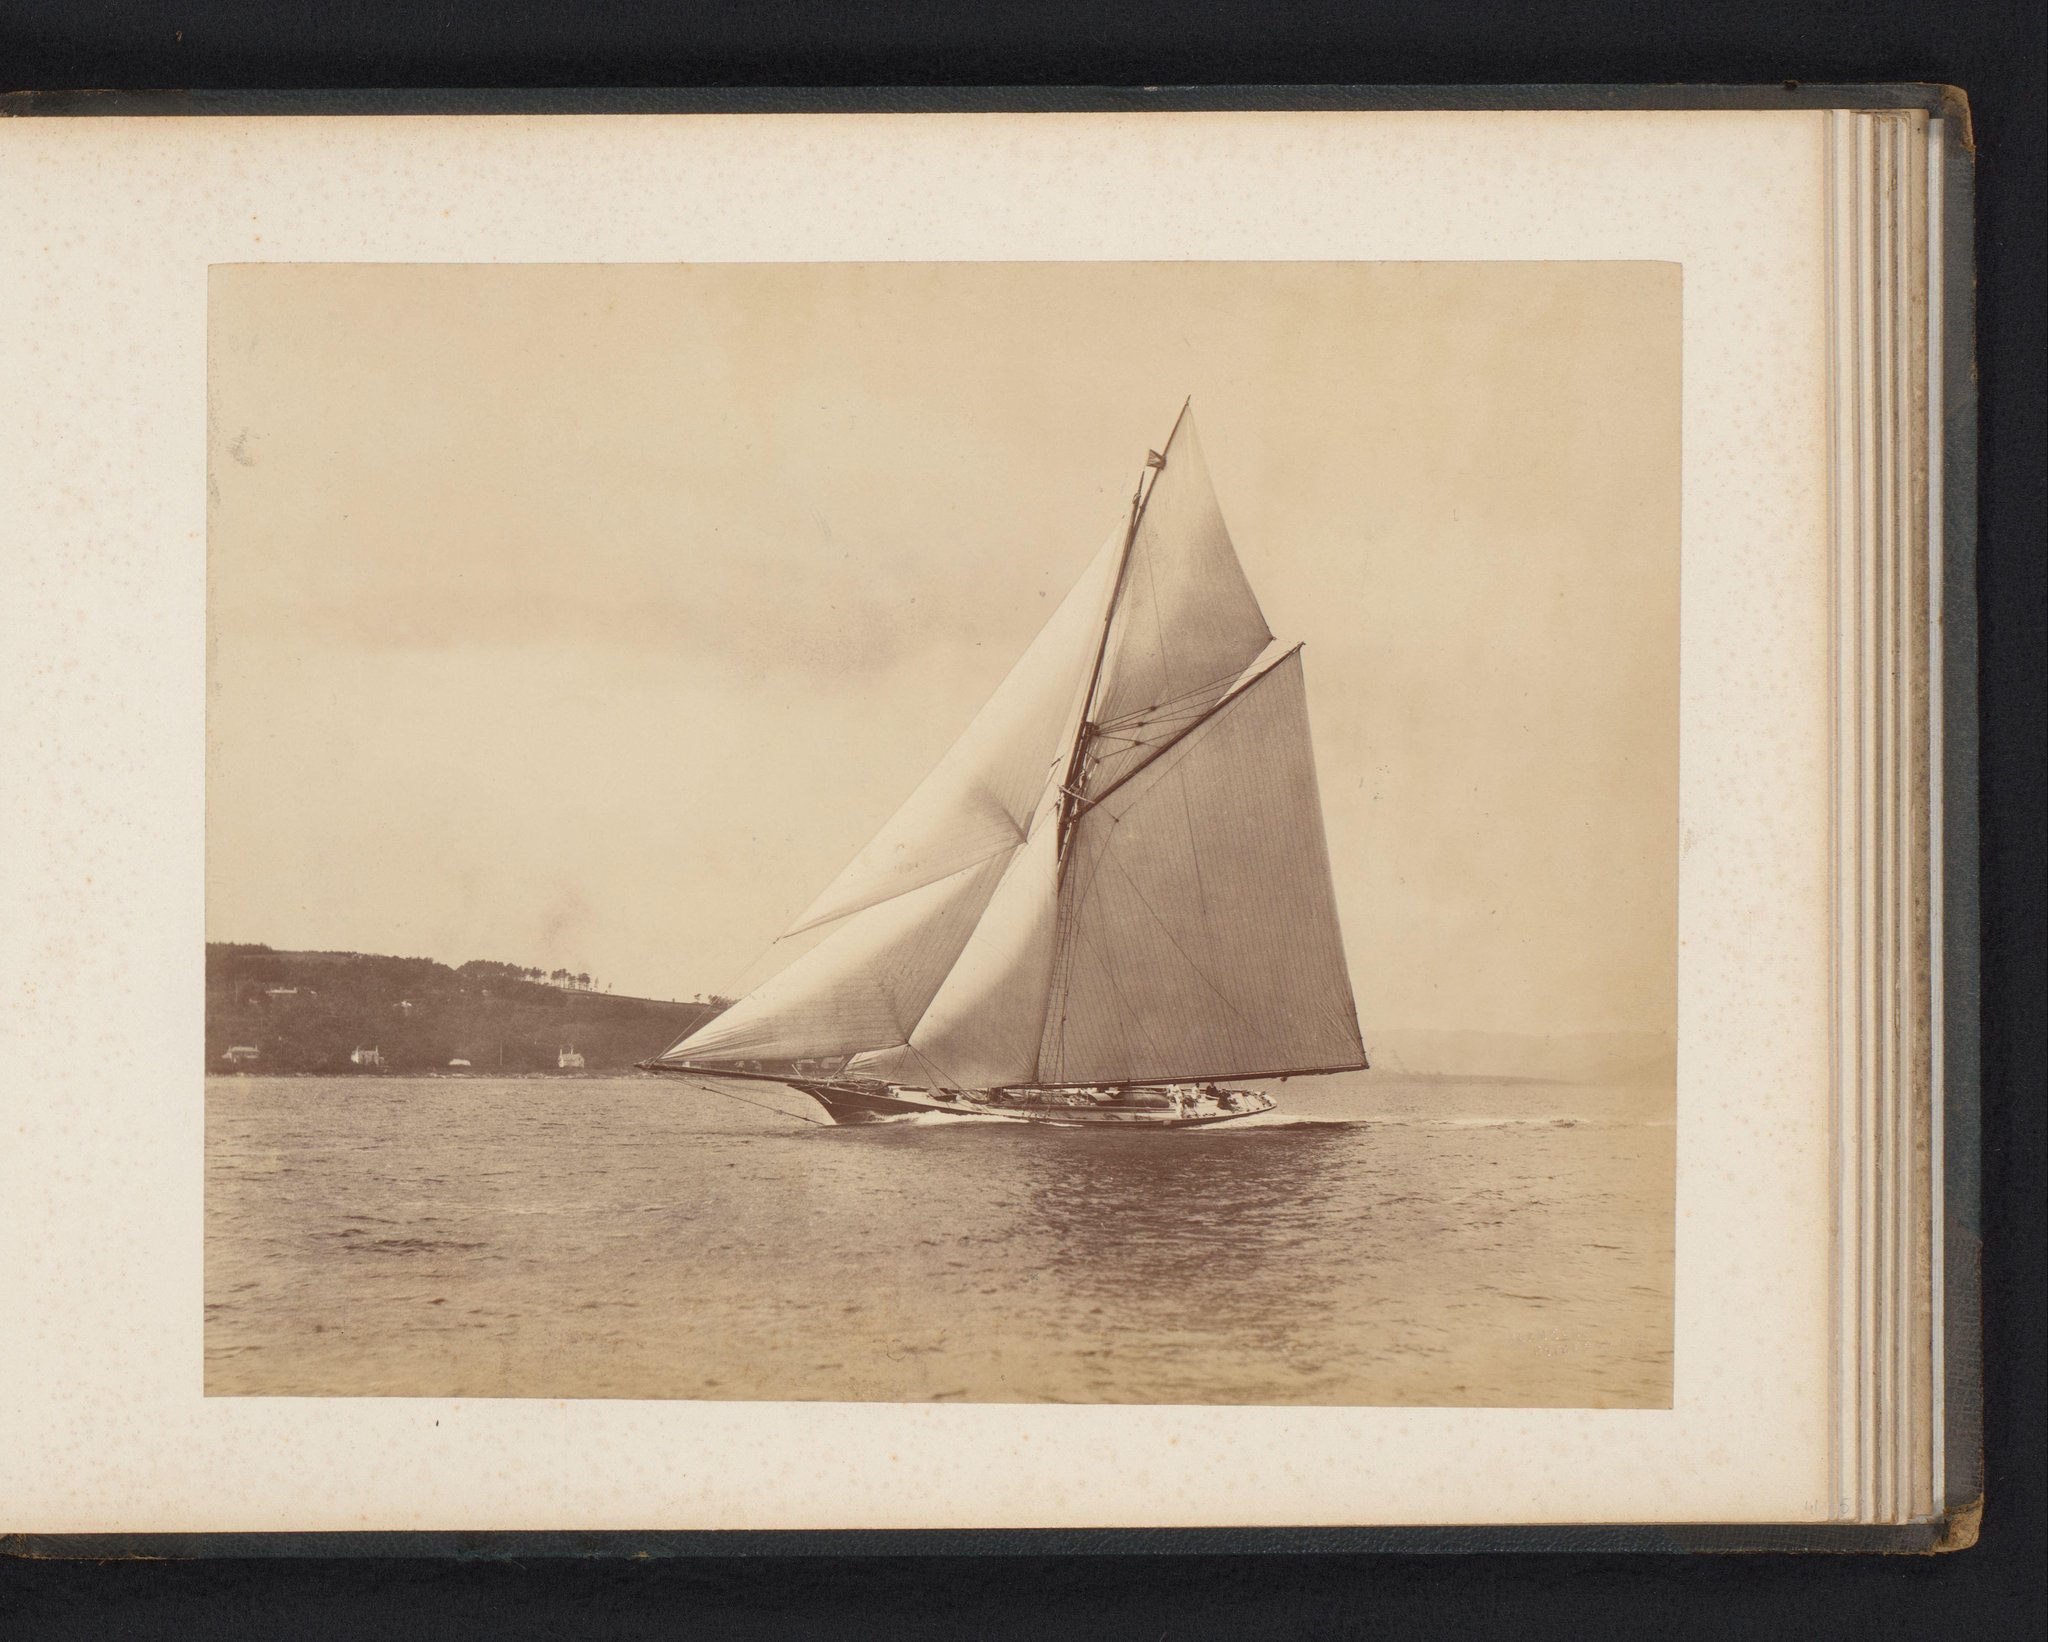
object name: album leaf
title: Zeilschip Valkyrie No.1 te water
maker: james adamson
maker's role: fotograaf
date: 1880-1900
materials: photographic support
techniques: albumen print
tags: sailing-ship, sailing-boat, landscapes with waters, waterscapes, seascapes (in the temperate zone)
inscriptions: check stamp: ‘Adamson, Rothesay.H.B/ Copyright’